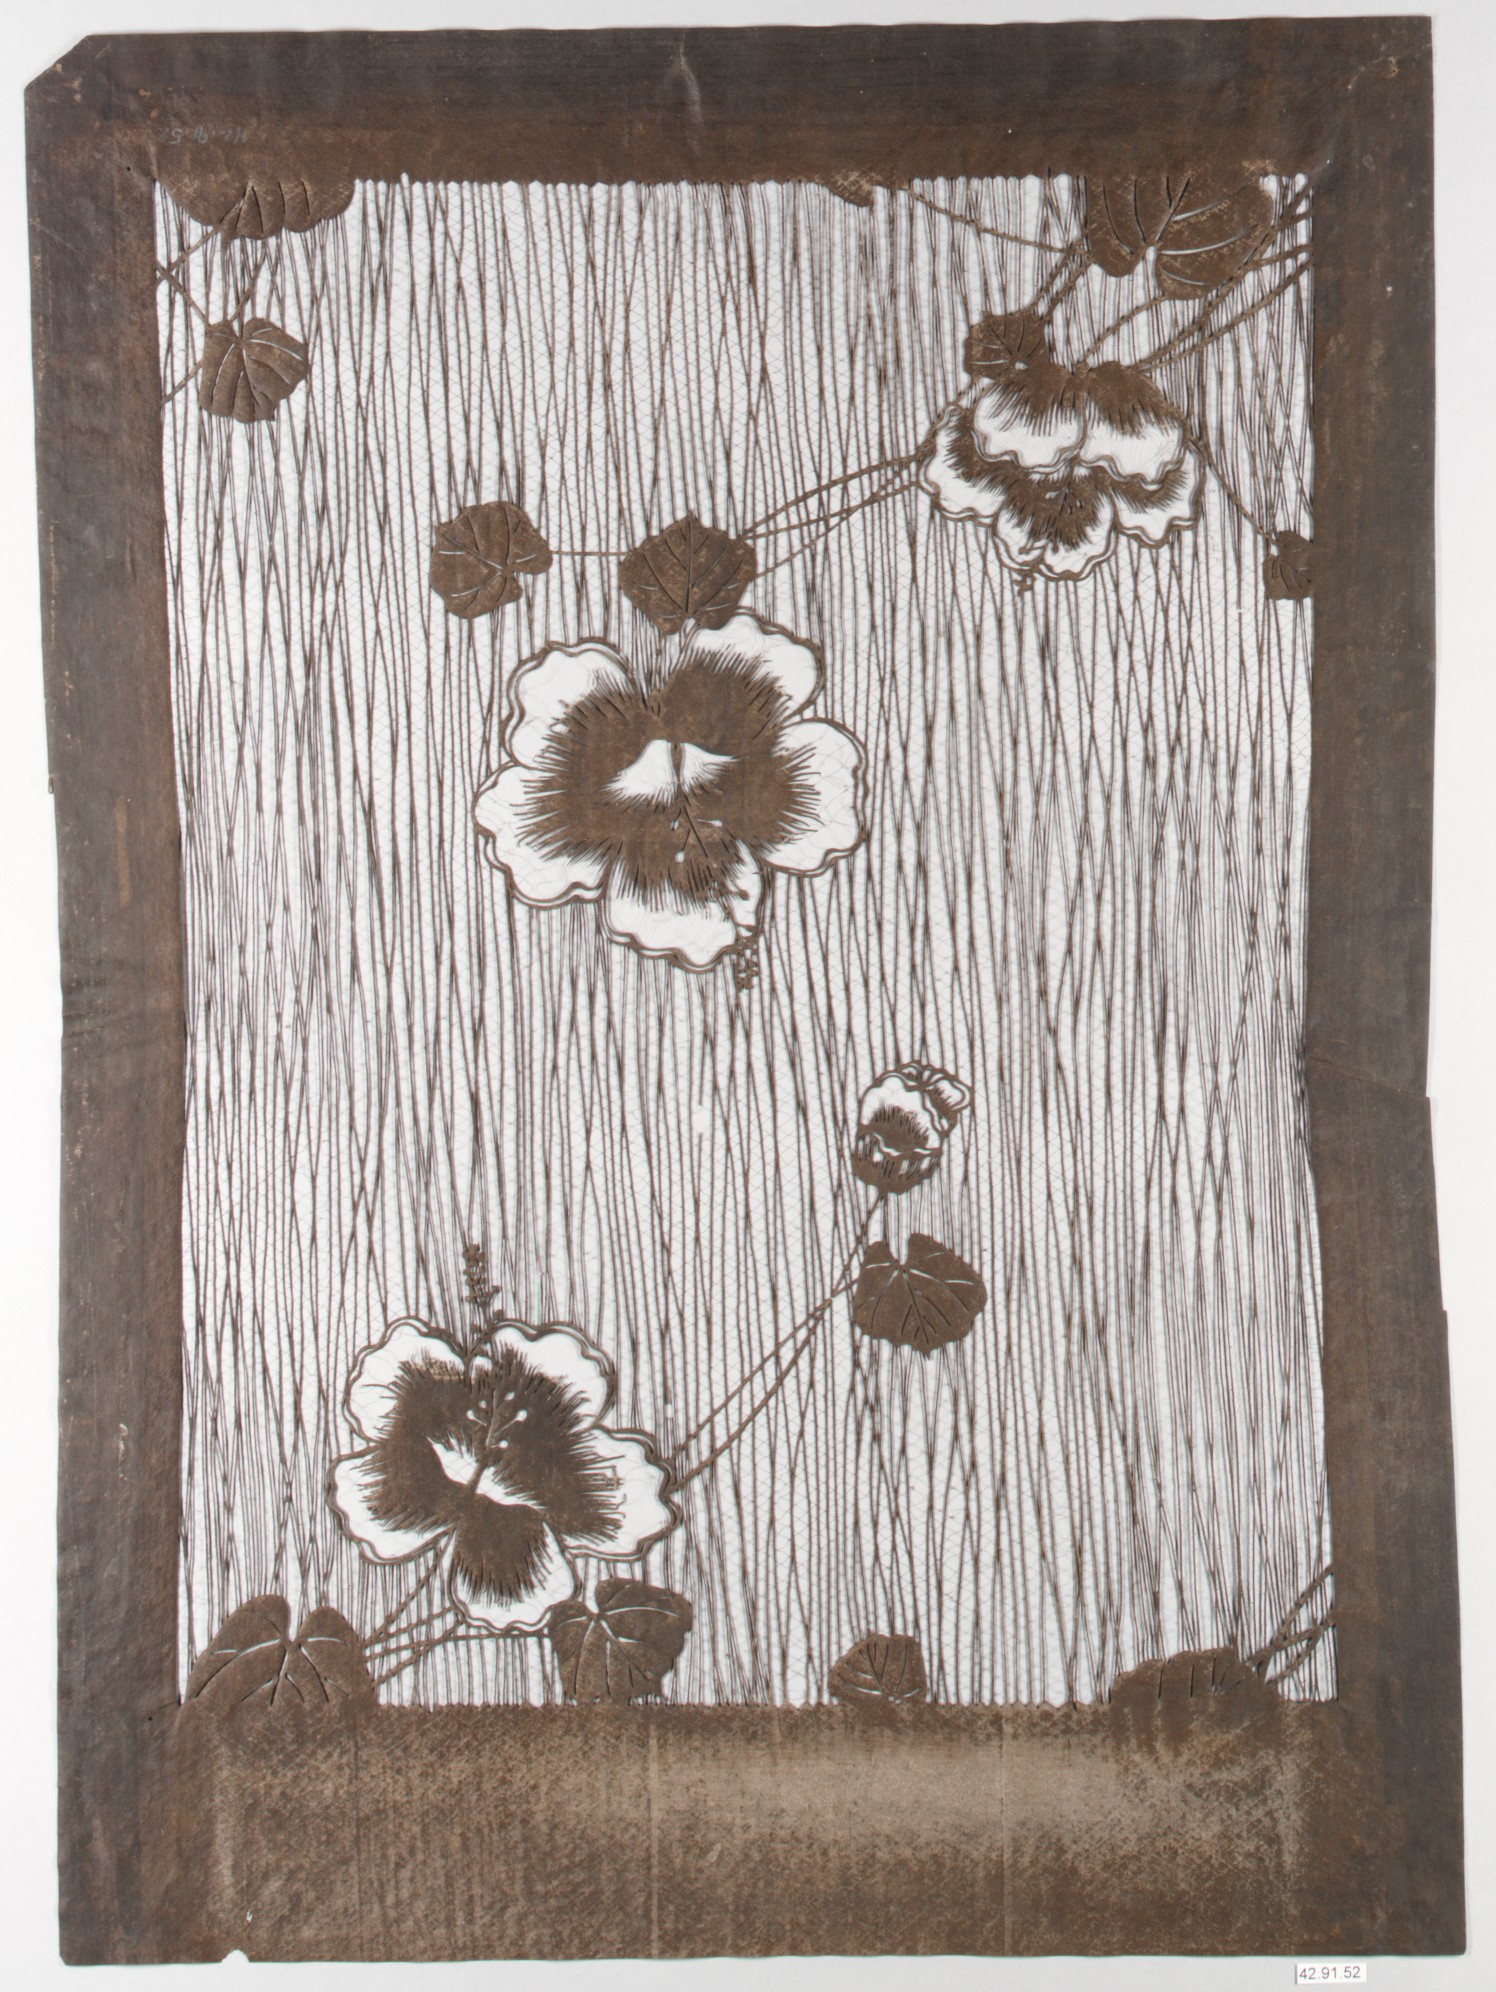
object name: stencil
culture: japanese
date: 1801-1900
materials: paper, silk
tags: flowers